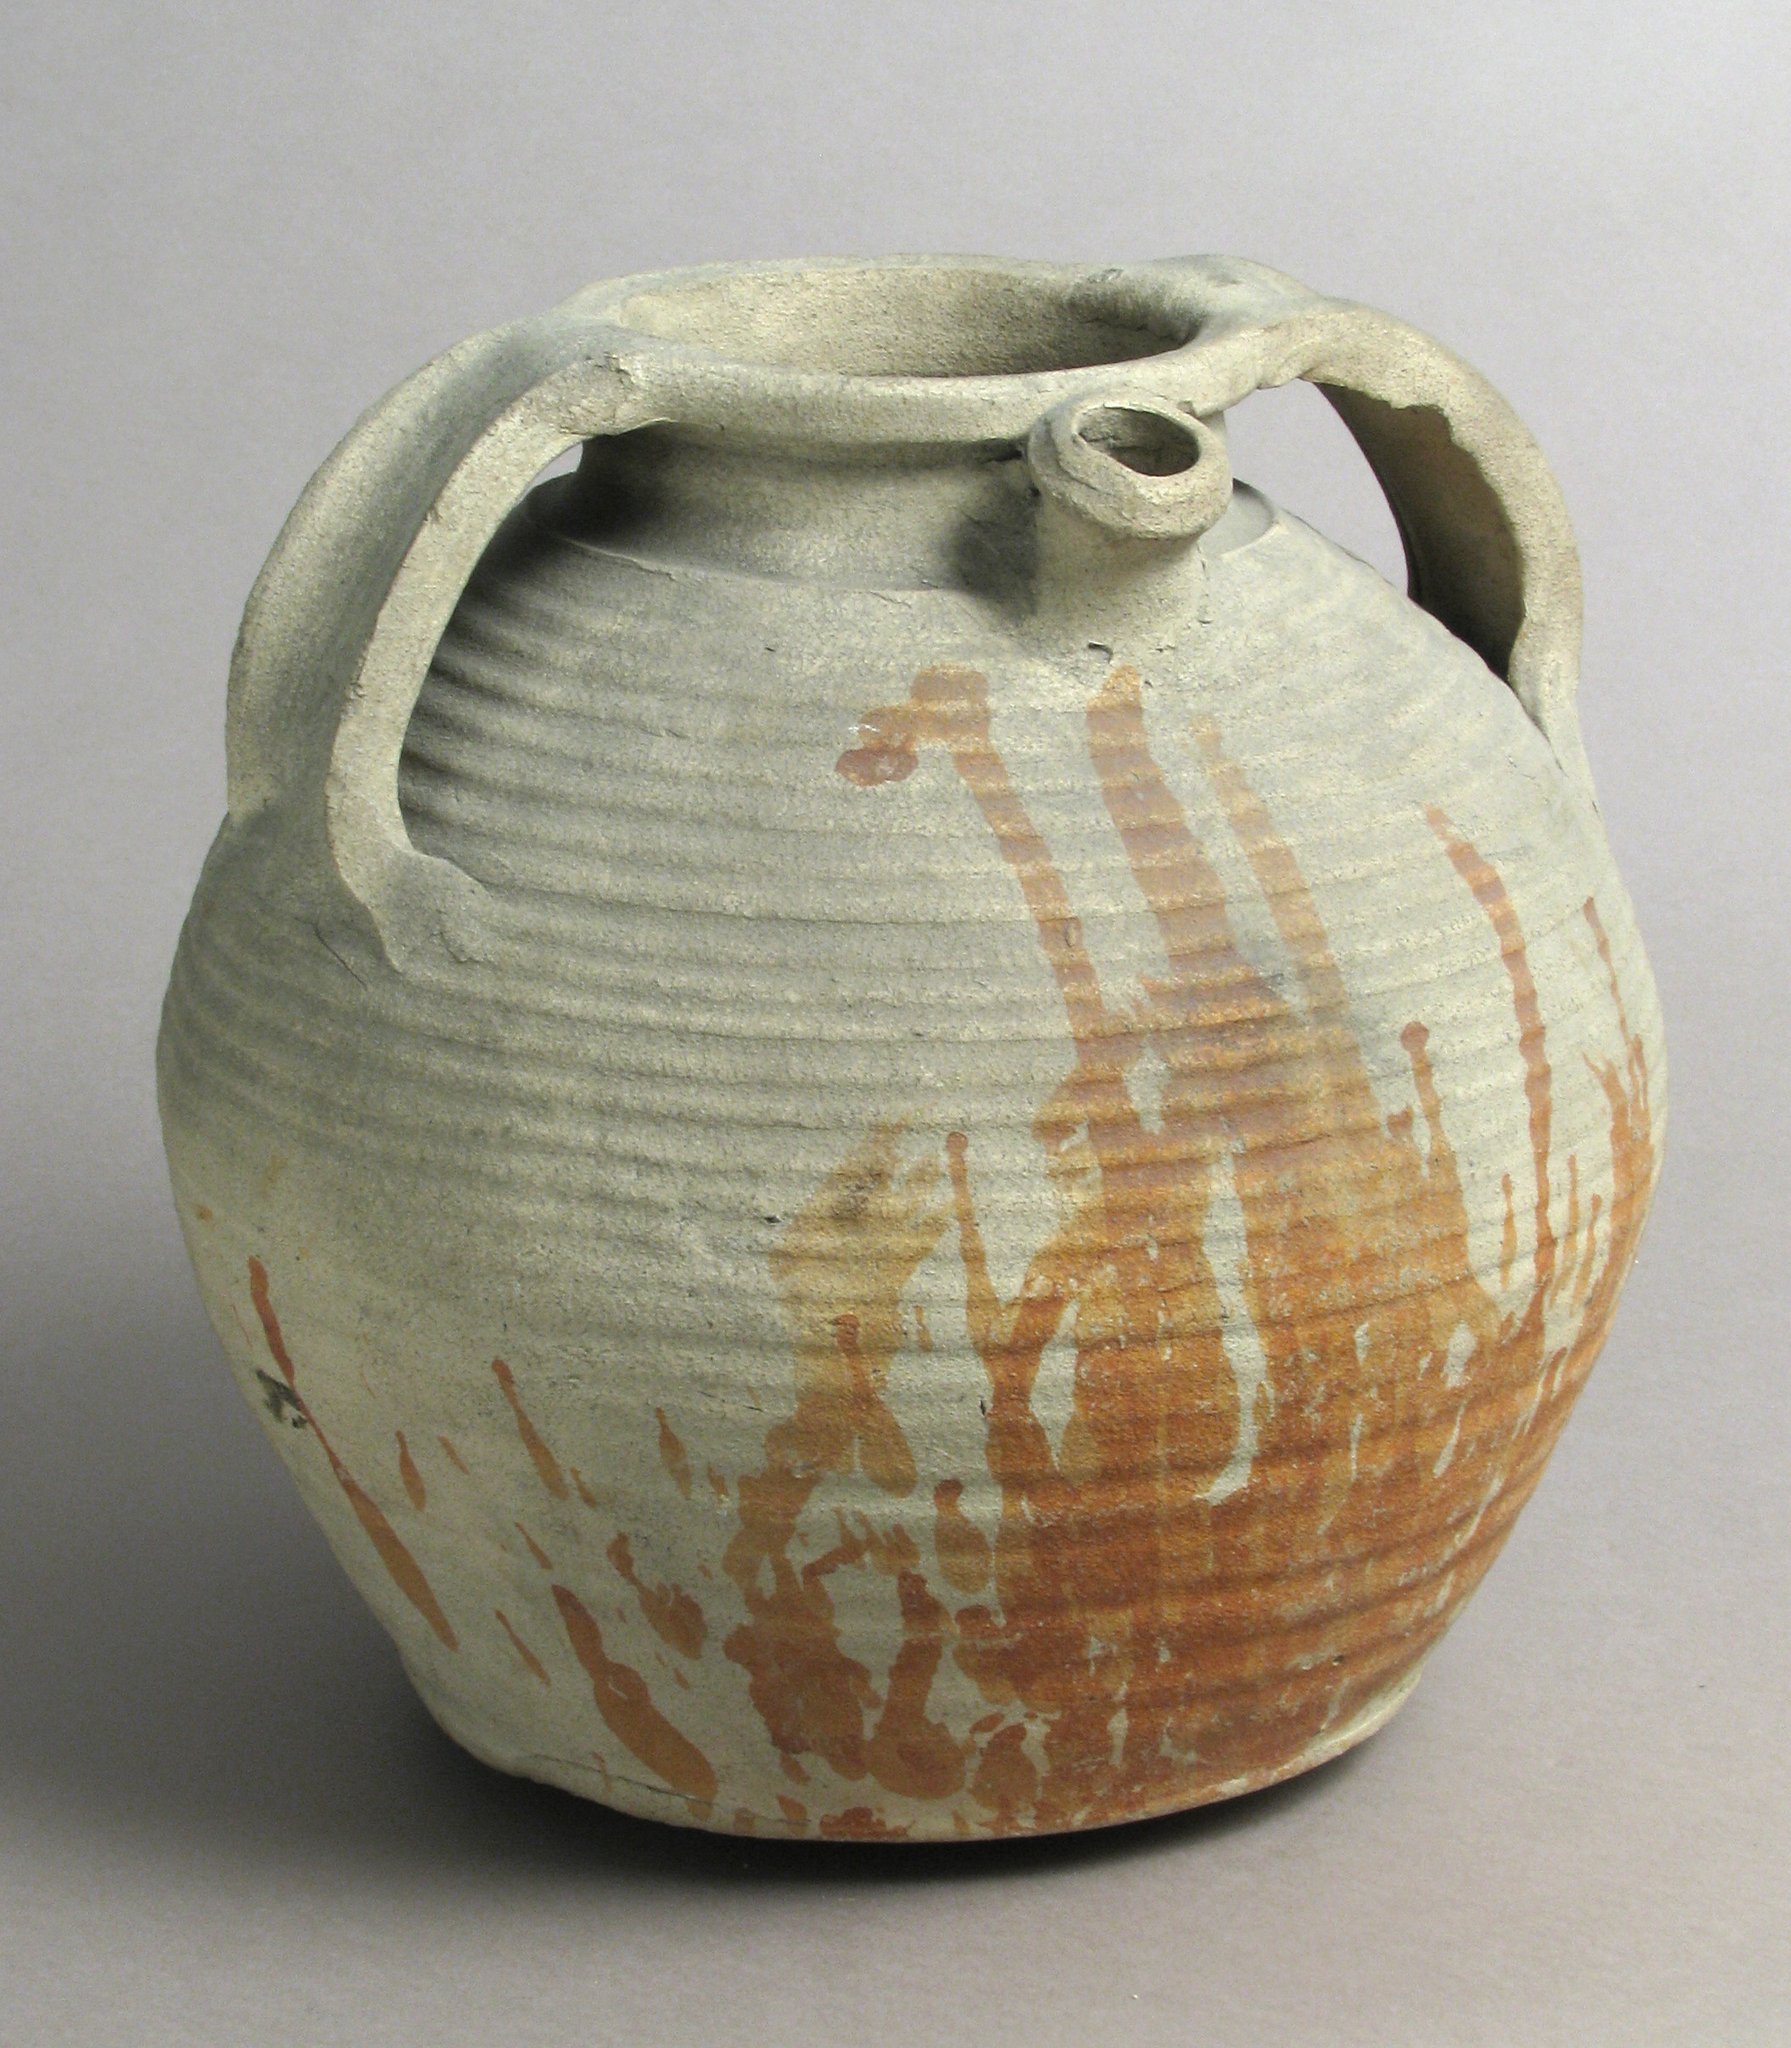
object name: jar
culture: french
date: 1201-1400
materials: earthenware